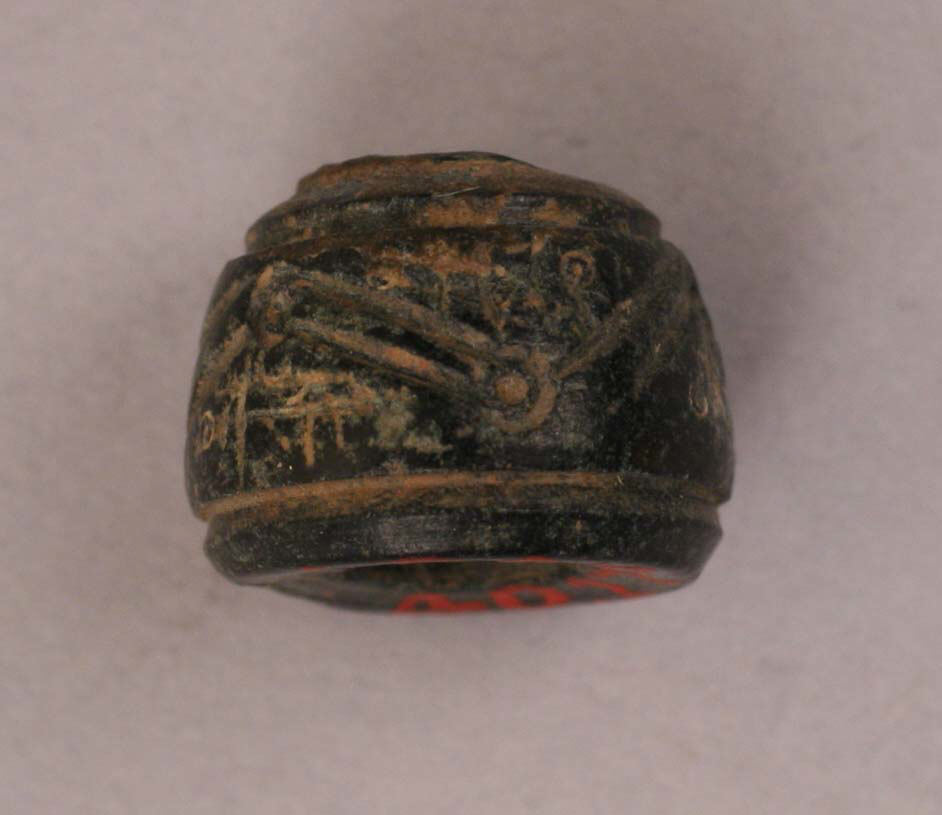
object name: button or bead or spindle whorl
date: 701-1000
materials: stone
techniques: incising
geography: iran